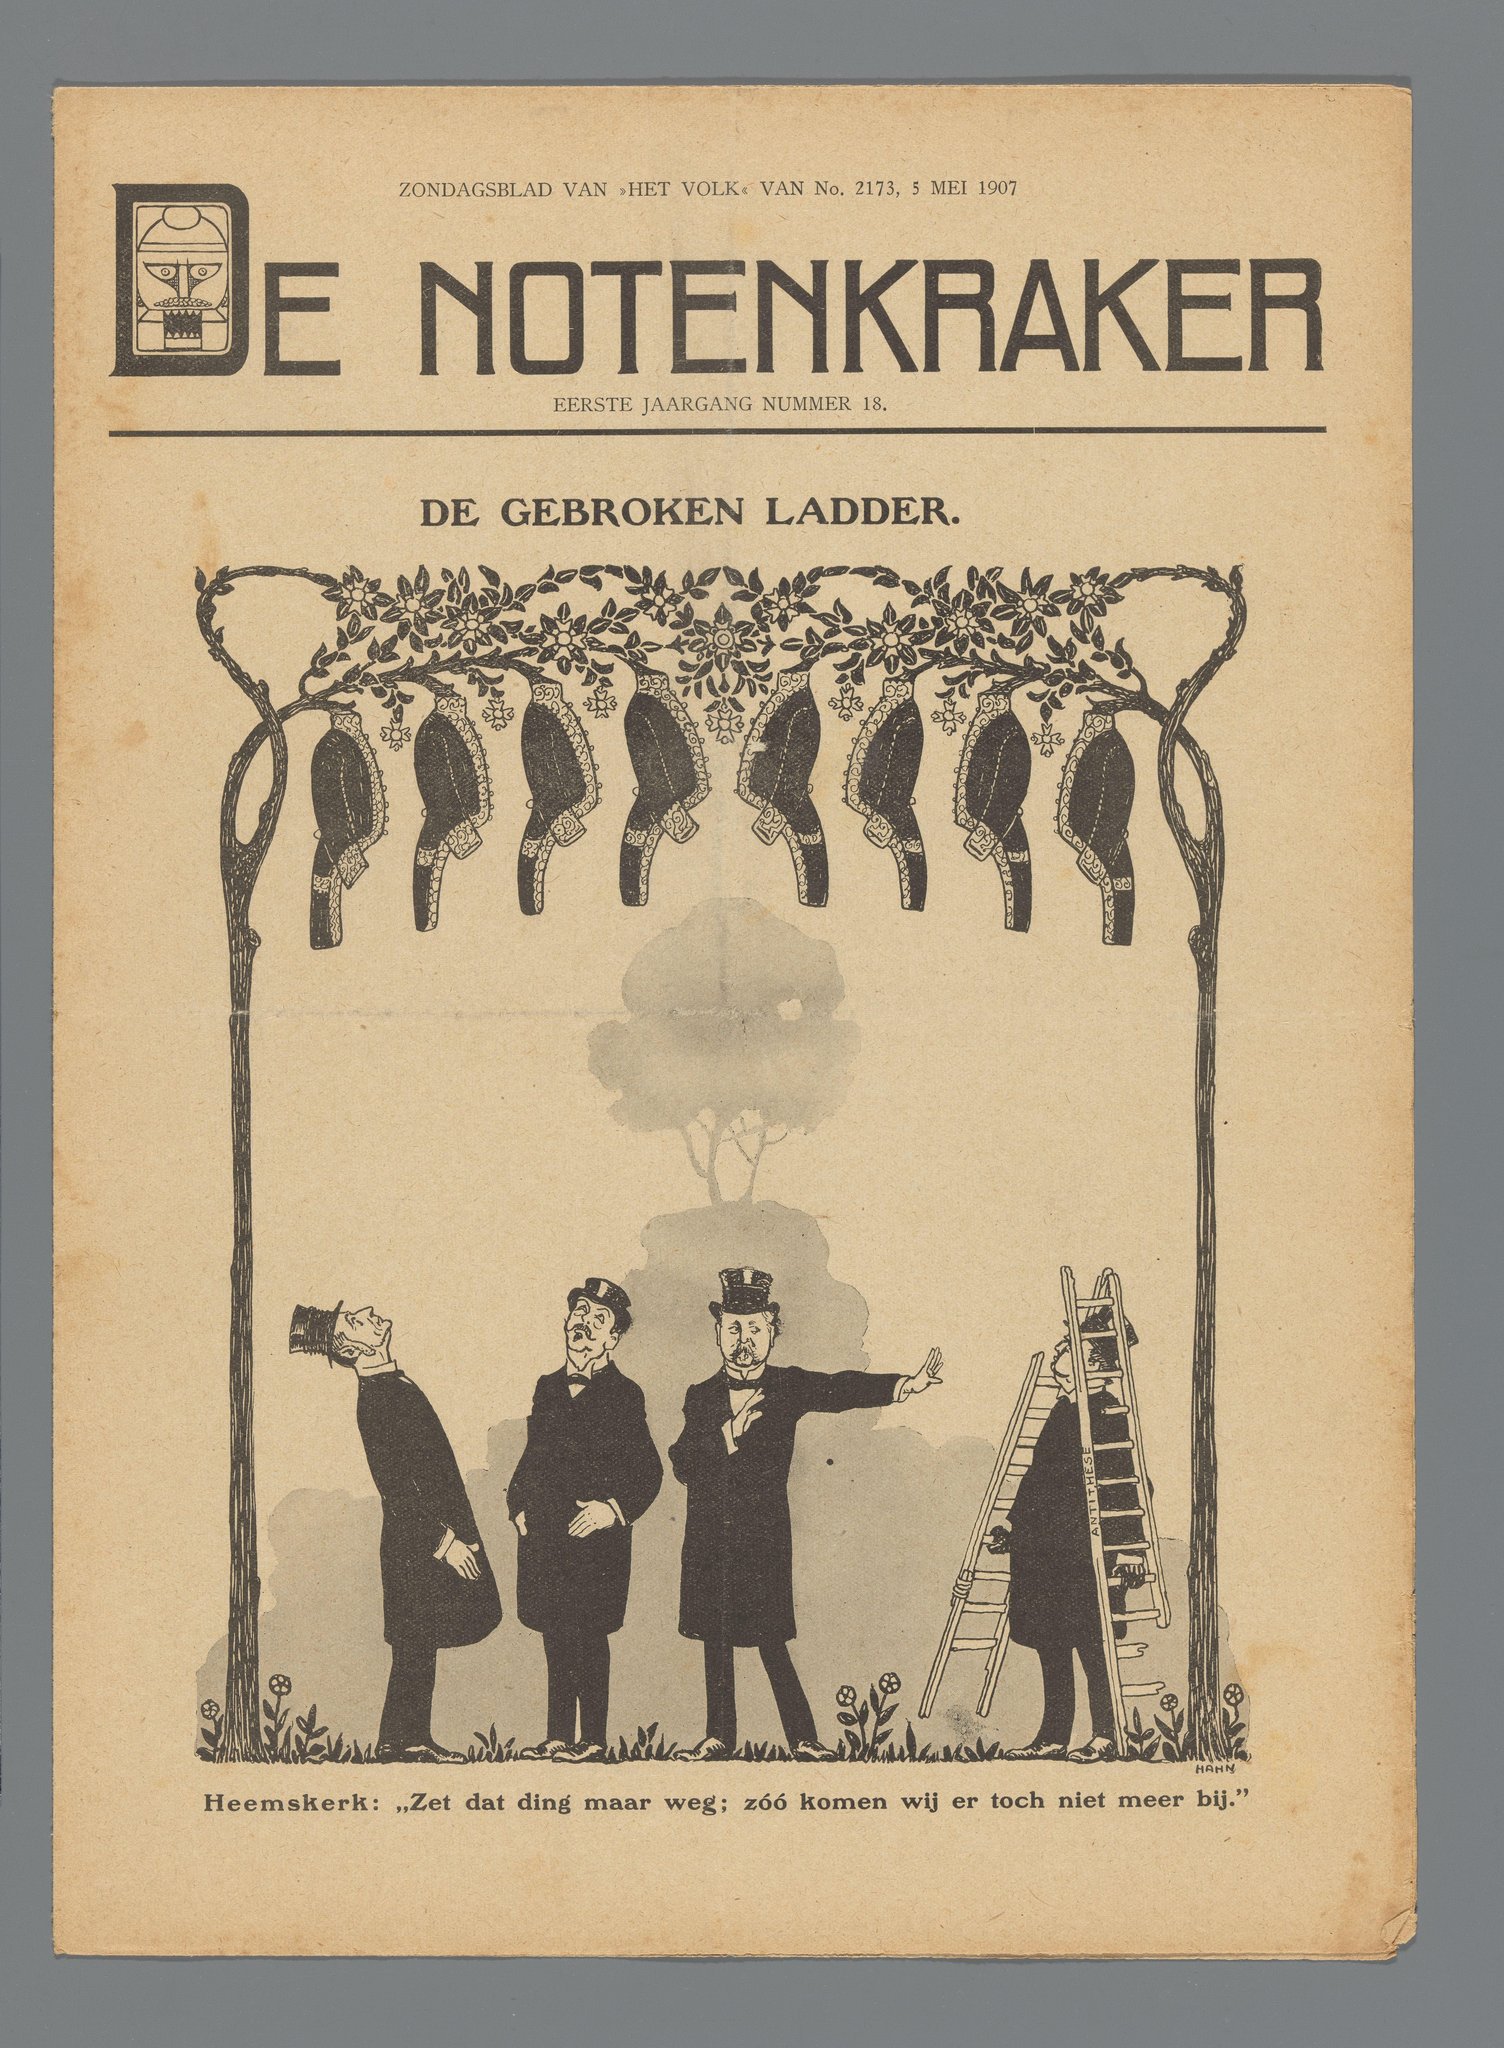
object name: print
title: De Notenkraker, 5 mei 1907 / De gebroken ladder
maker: albert hahn (i)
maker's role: draughtsman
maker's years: 1877-1918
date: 1907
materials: paper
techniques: lithograph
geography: amsterdam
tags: jonkheer alexander frederik de savornin lohman, abraham kuyper, amsterdam, utrecht, minister ~ government, political caricatures and satires, netherlands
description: Aflevering van het satirische tijdschrift De Notenkraker van 5 mei 1907, eerste jaargang, nummer 18. Omslag met illustratie van Heemskerk, Kuypers, de Savornin Lohman en een andere man die het niet lukt om met een ladder bij de hoog gehangen ministeriële ambtskostuums te geraken. Onderdeel van een volledige eerste jaargang (1907). Elk nummer bevat 8 bladzijden, deels nog niet losgesneden, met op de voorzijde steeds een spotprent van Albert Hahn, op de overige pagina's prenten van Hahn steeds tussen de tekst. In de letter 'D' van de titel is een kop van een zgn. notenkraker afgebeeld.